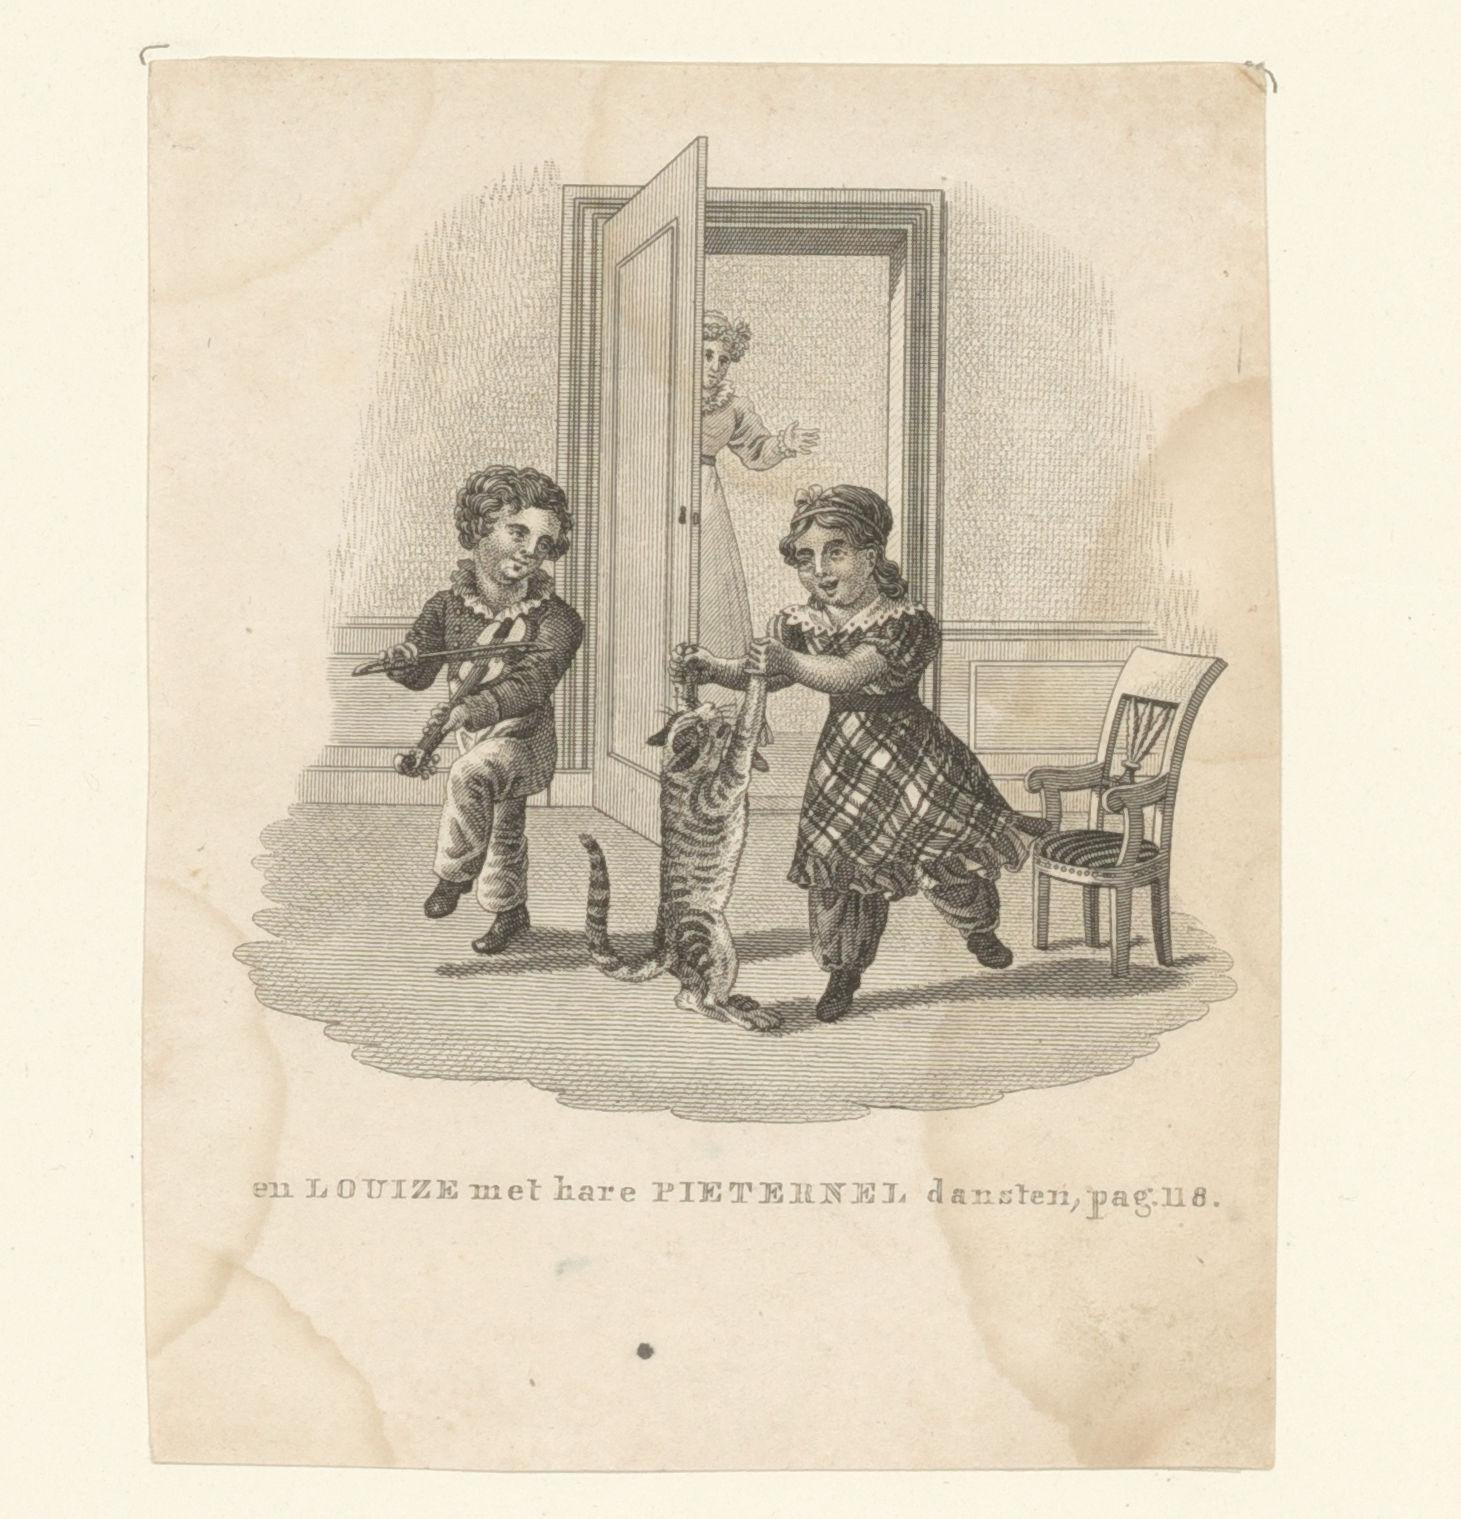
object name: book illustration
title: Twee kinderen dansen met een kat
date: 1835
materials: paper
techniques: etching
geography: deventer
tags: dancing, cat, child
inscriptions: collector's mark: Lugt 1641, stamp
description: Rechtsonder genummerd: pag. 118. Onderwerpsrubrieken binnen de Atlas Zeden en Gewoonten: Zeden en Gewoonten in Engeren Zin, Des menschen beging, midden en einde, Kinderleven – Kinderspel en Kinderprenten.